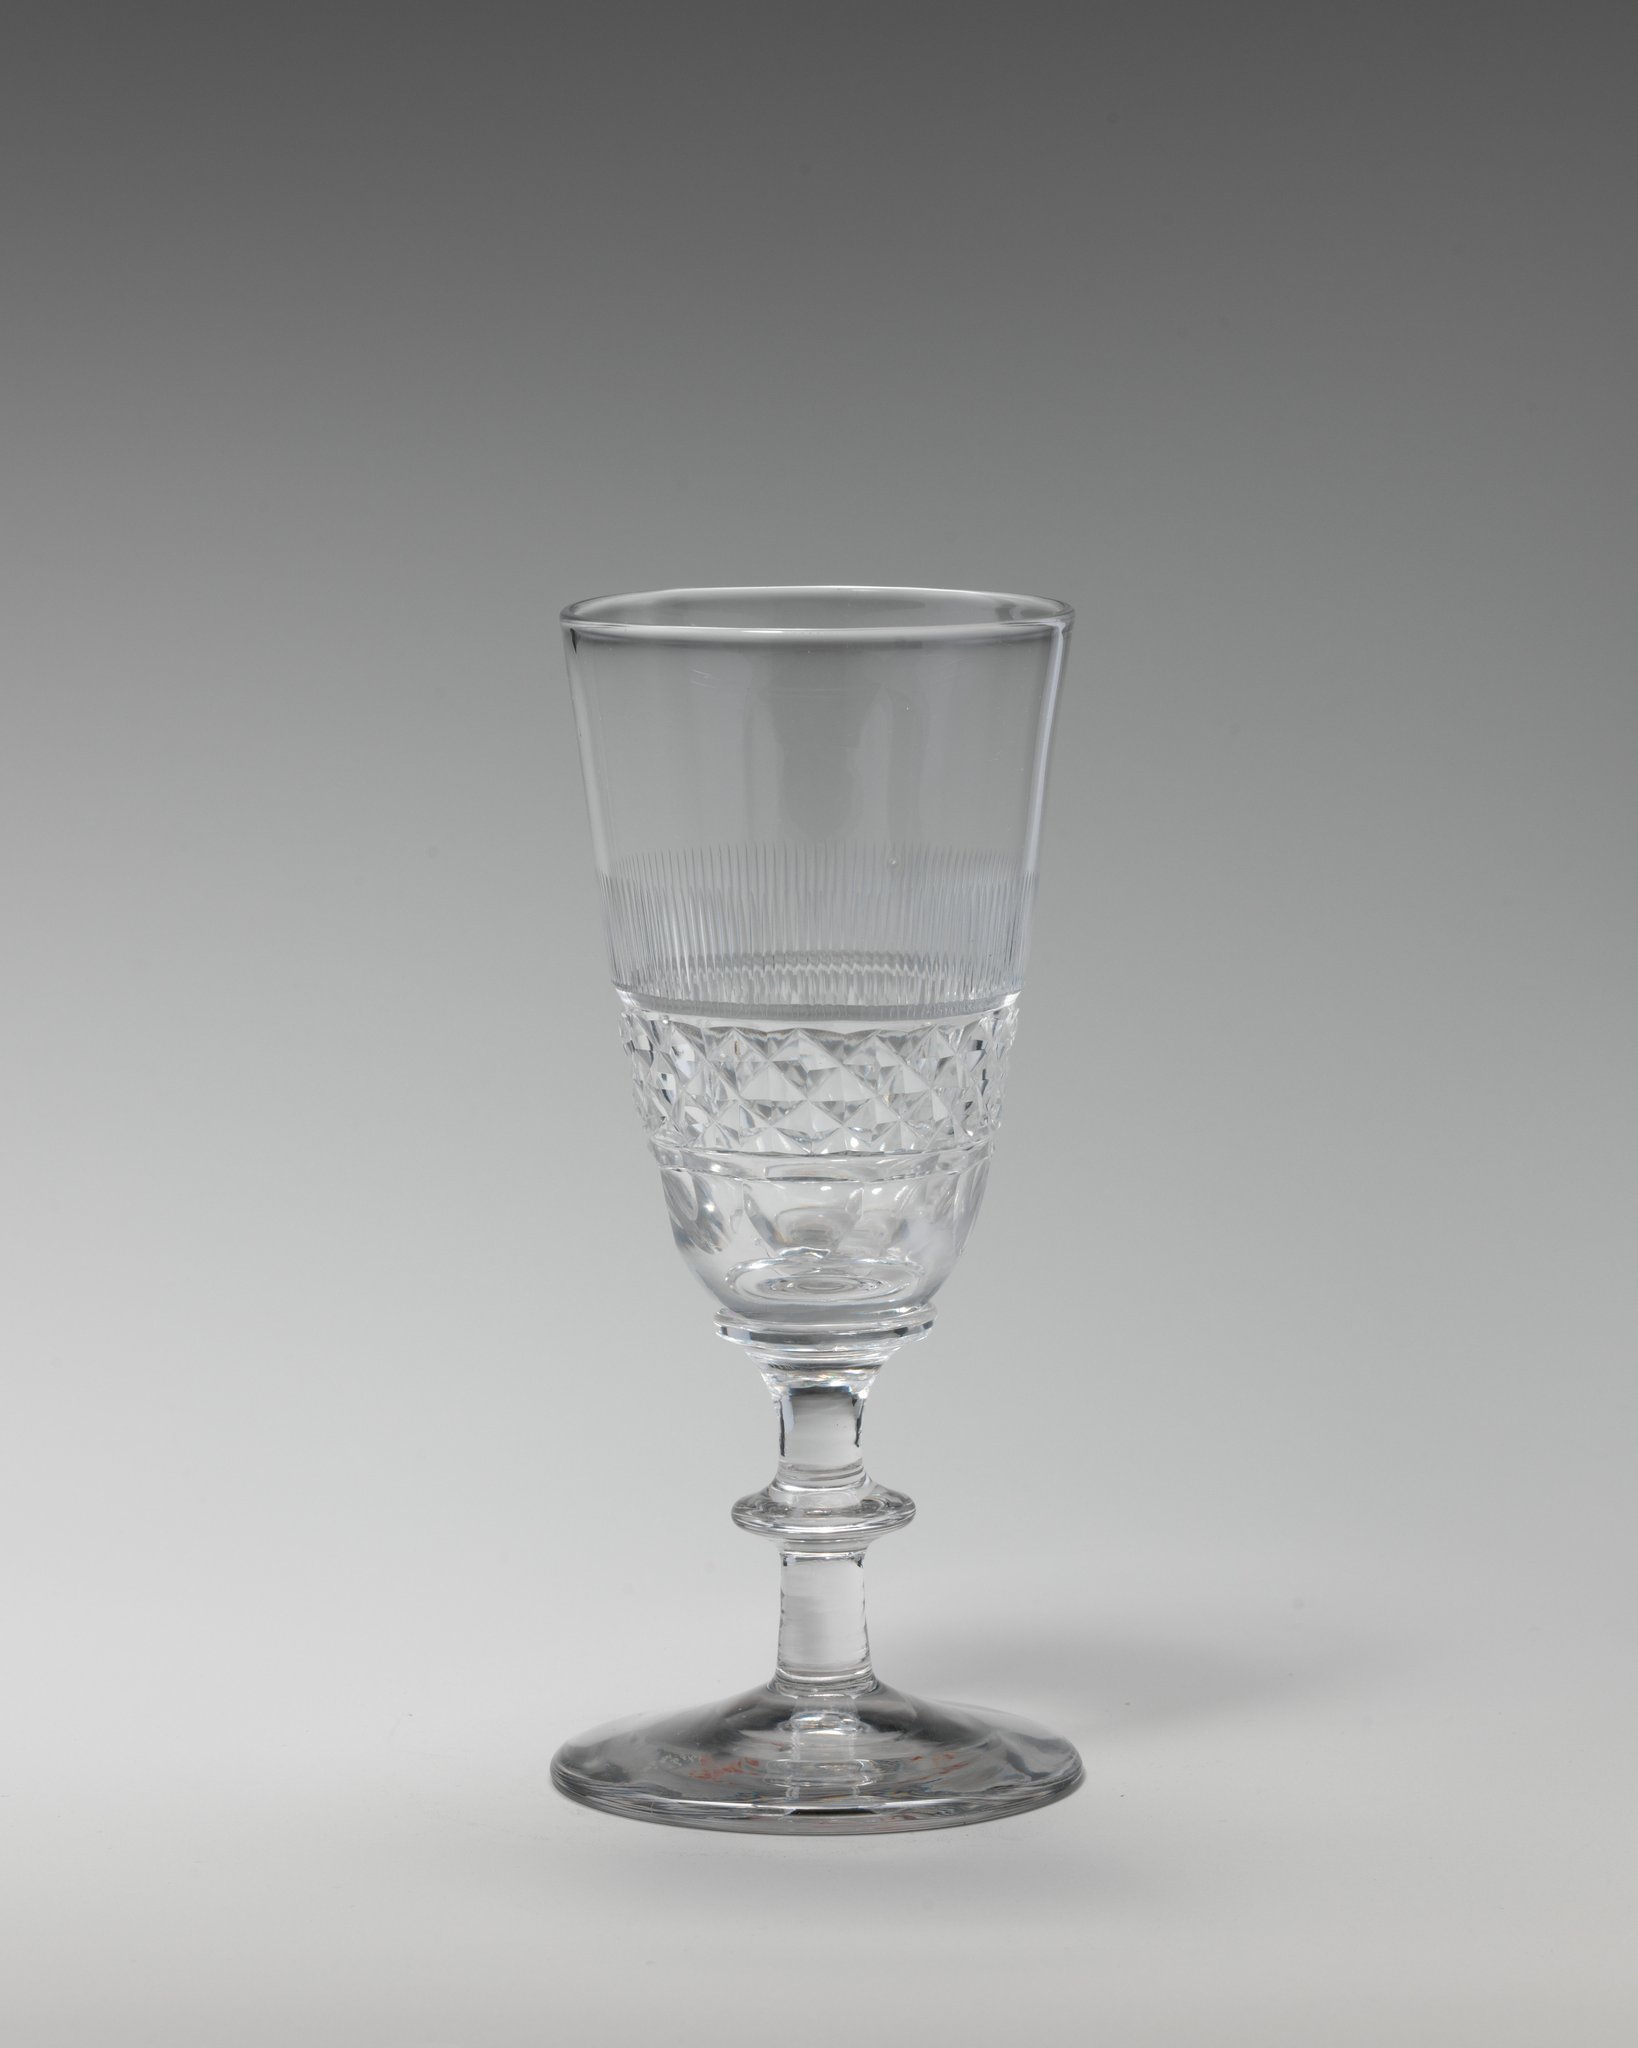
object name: wineglass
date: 1701-1800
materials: glass